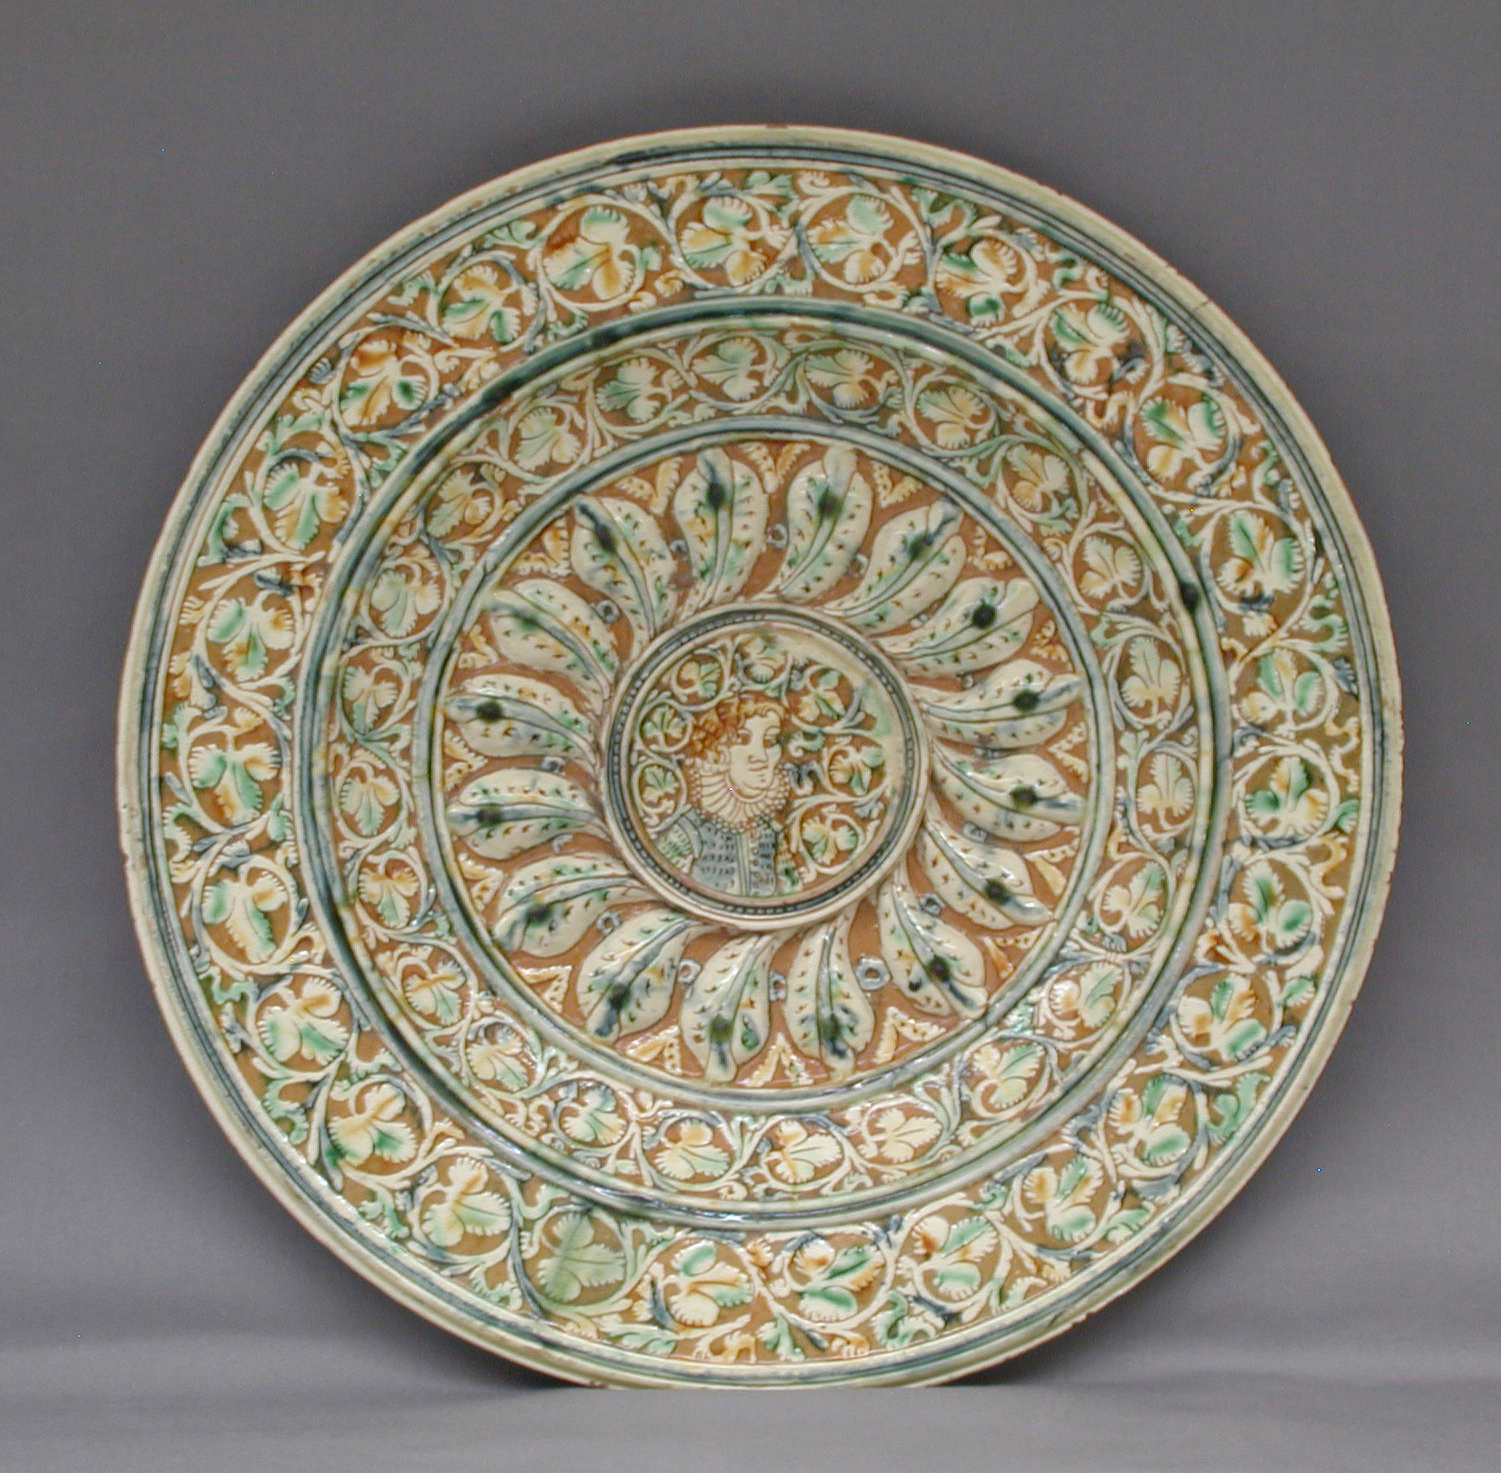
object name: plate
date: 1580-1600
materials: earthenware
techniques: glazing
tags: portraits